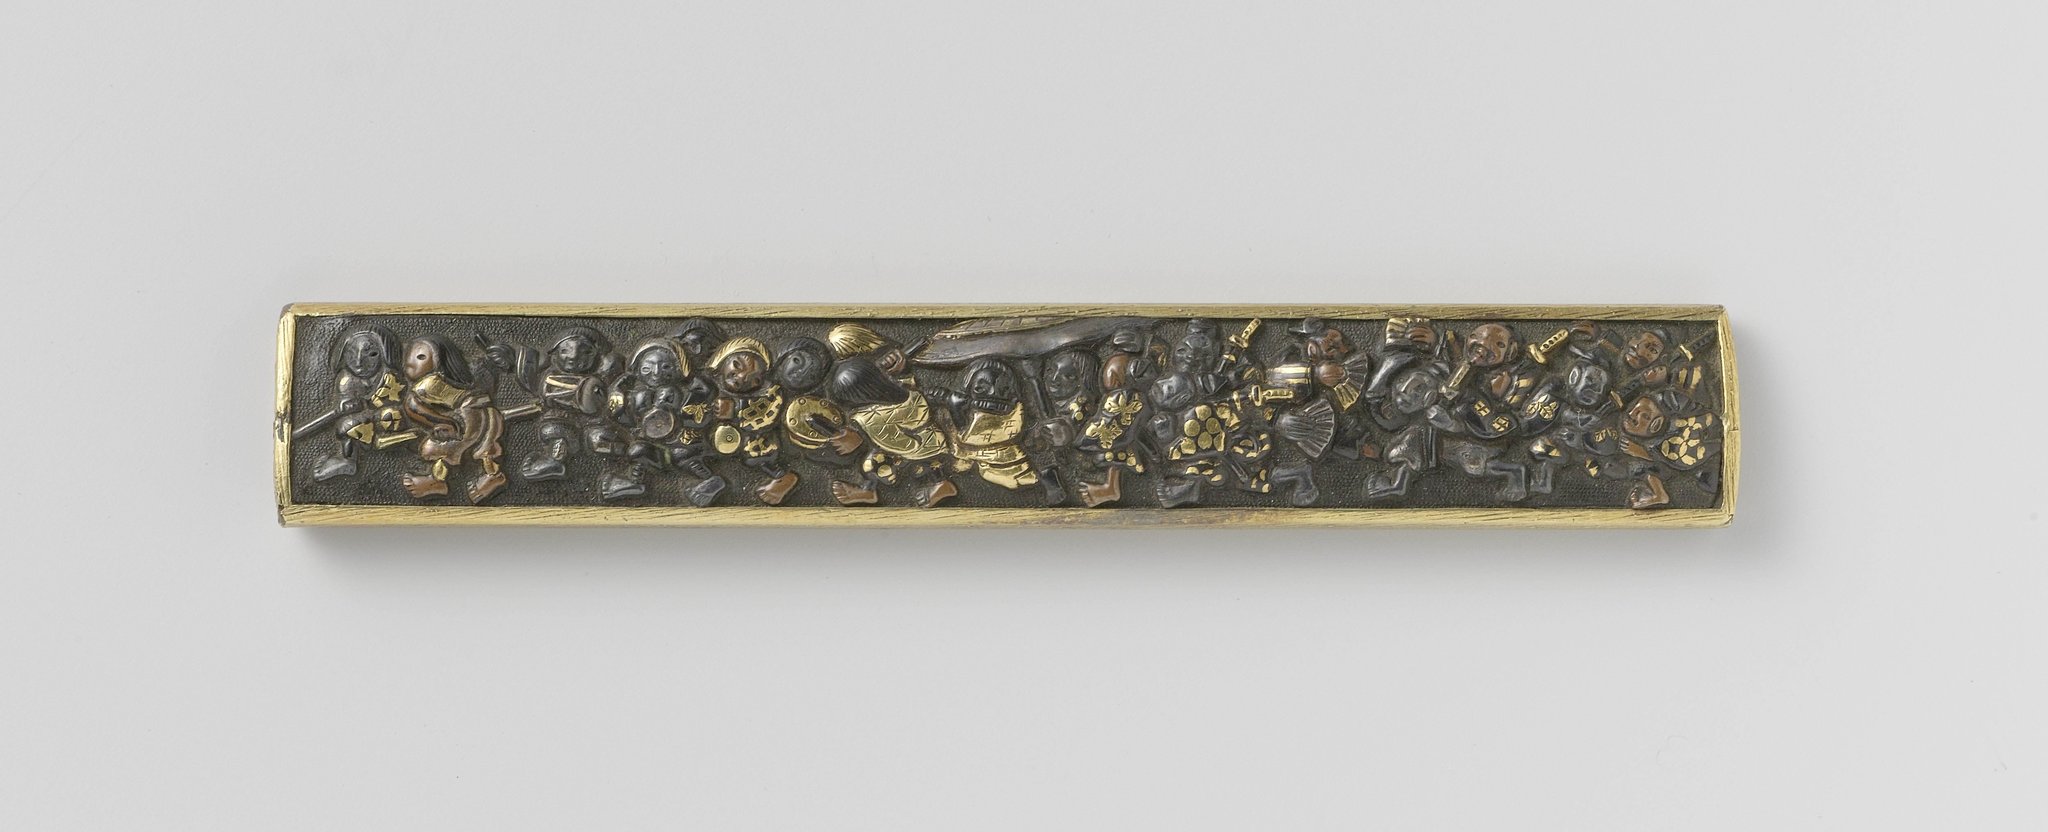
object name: zwaardmesheft, kozuka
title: Sword knife hilt with procession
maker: Anonymous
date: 1800-1900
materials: gold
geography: japan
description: Voorstelling van een rij musicerende mensen in relief; om de voorstelling een gouden rand.